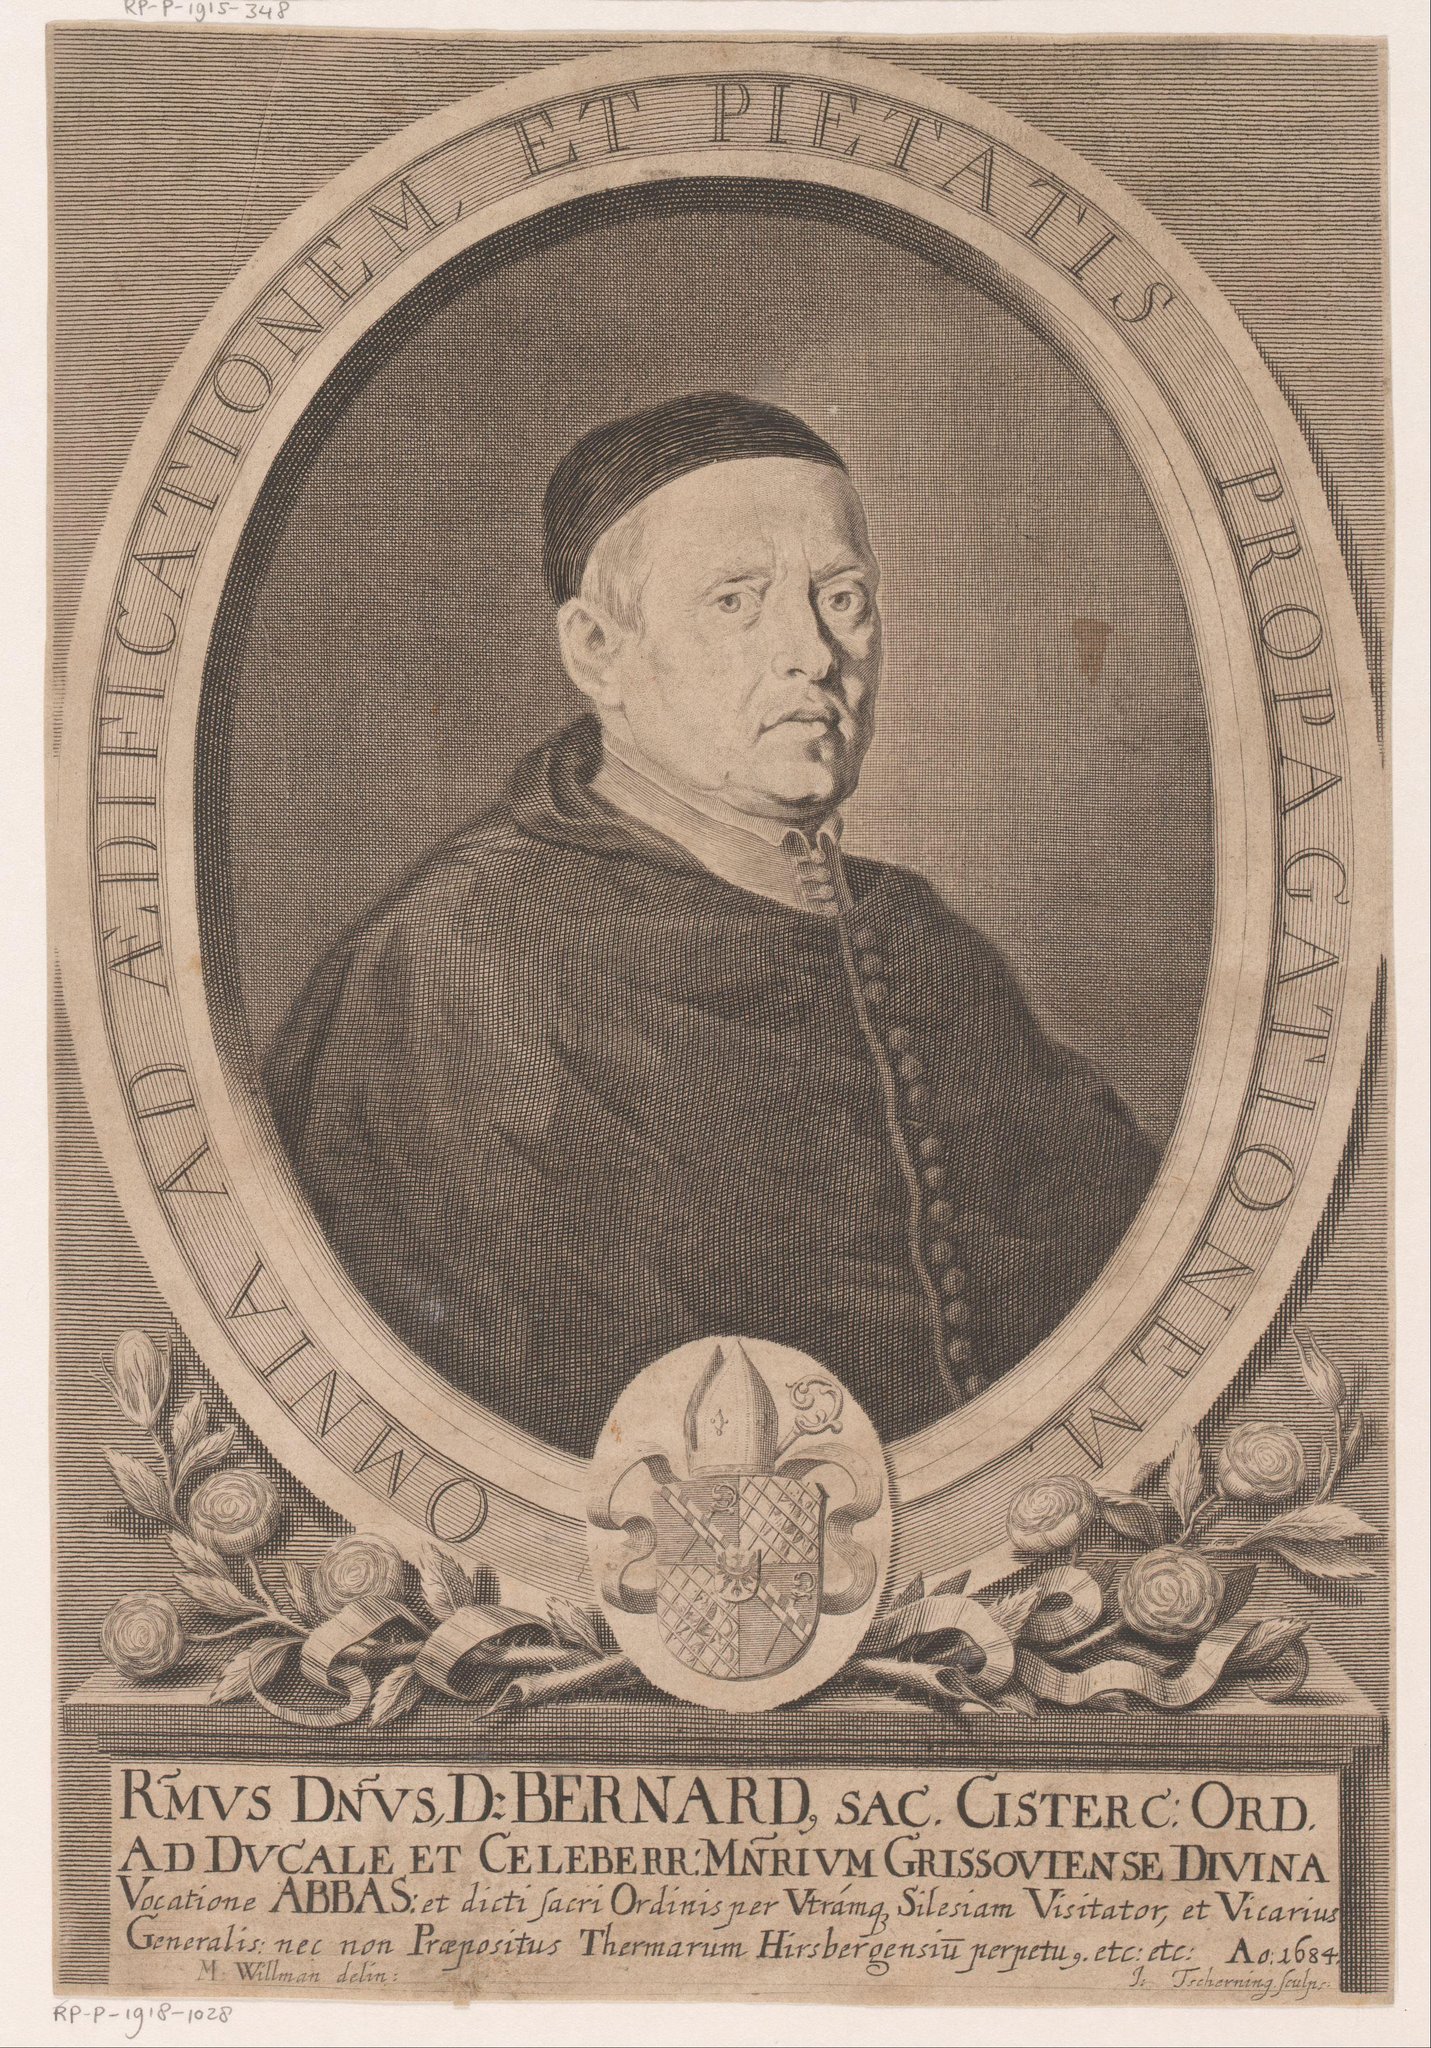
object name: print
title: Portret van Bernhard Rosa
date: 1684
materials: paper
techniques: engraving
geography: germany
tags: historical persons, armorial bearing, heraldry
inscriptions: collector's mark: Lugt 2233